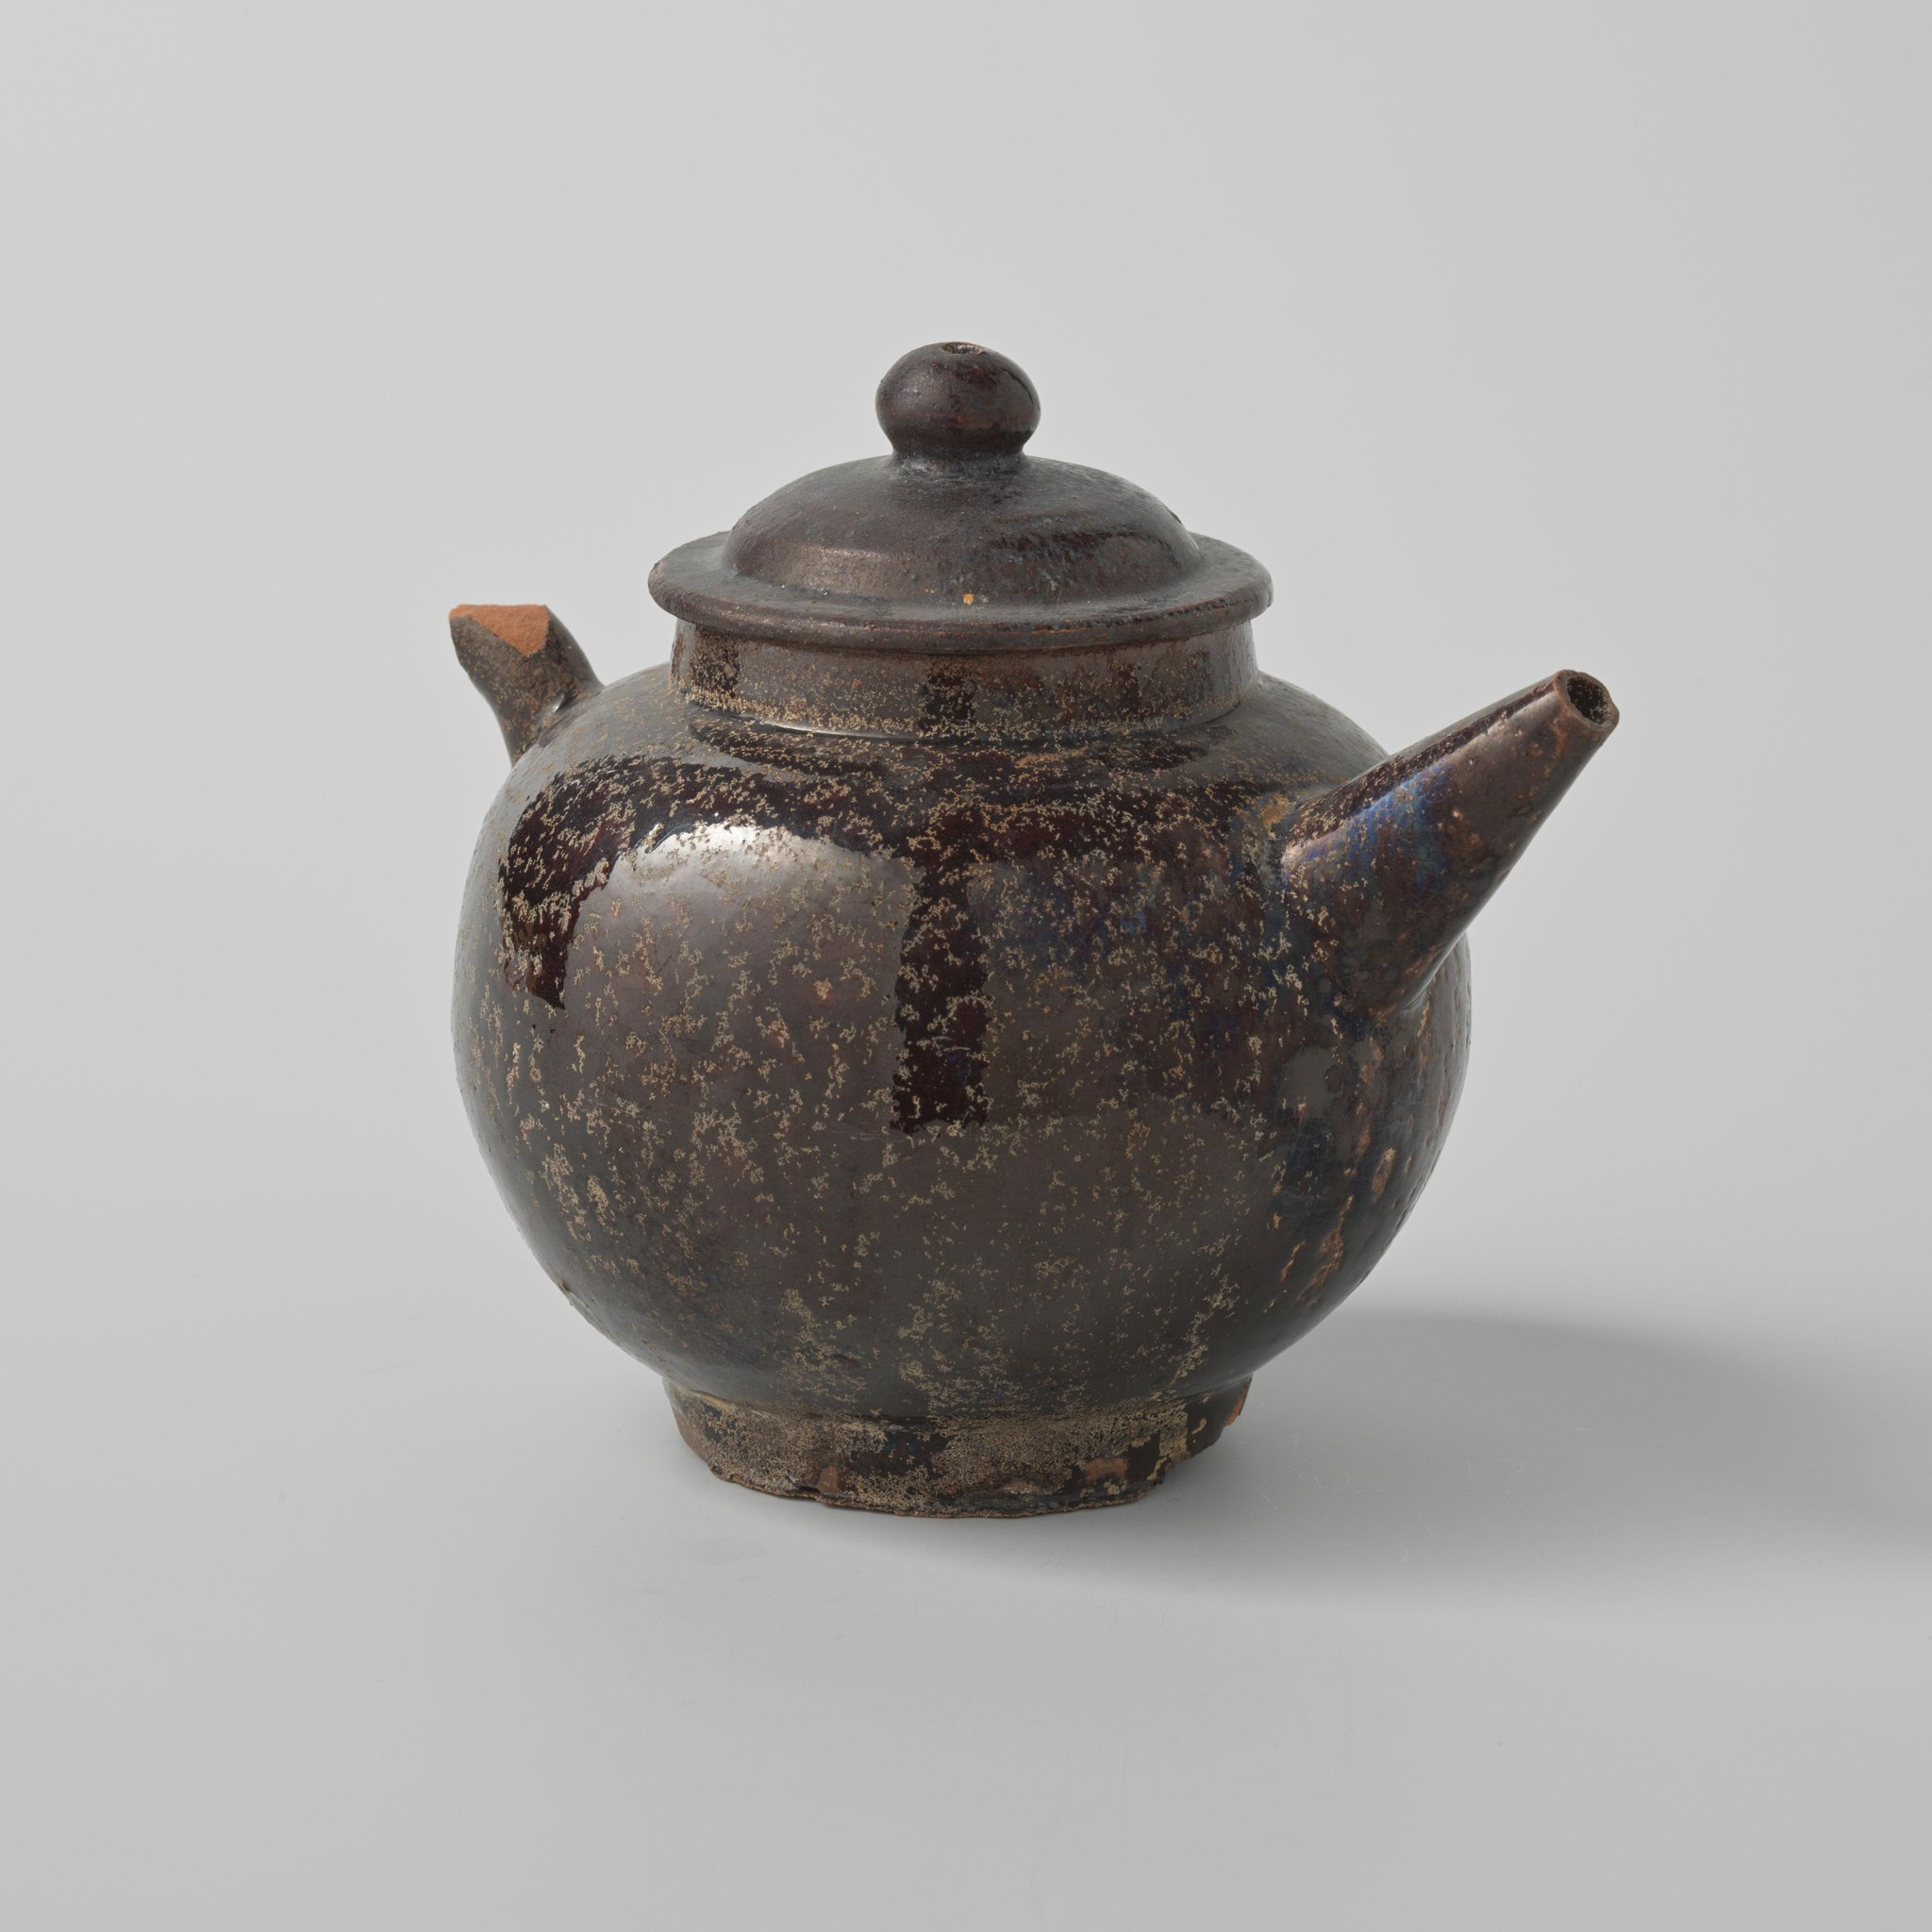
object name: teapot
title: Theepot (De Caluwe bakafval)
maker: jacobus de caluwe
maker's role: plateelbakkerij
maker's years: -1730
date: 1700-1725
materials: earthenware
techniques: firing, vitrification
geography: delft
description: Toegeschreven aan Jacobus de Caluwe, omdat dit voorwerp samen met gemerkte stukken (‘Jacobus De Caluwe’ en rennend hert) gevonden is op de plaats waar zich De Caluwes tweede werkplaats bevond. Er is een duidelijke stilistische overeenkomst tussen de gemerkte en niet gemerkte voorwerpen uit deze archeologische vondst.